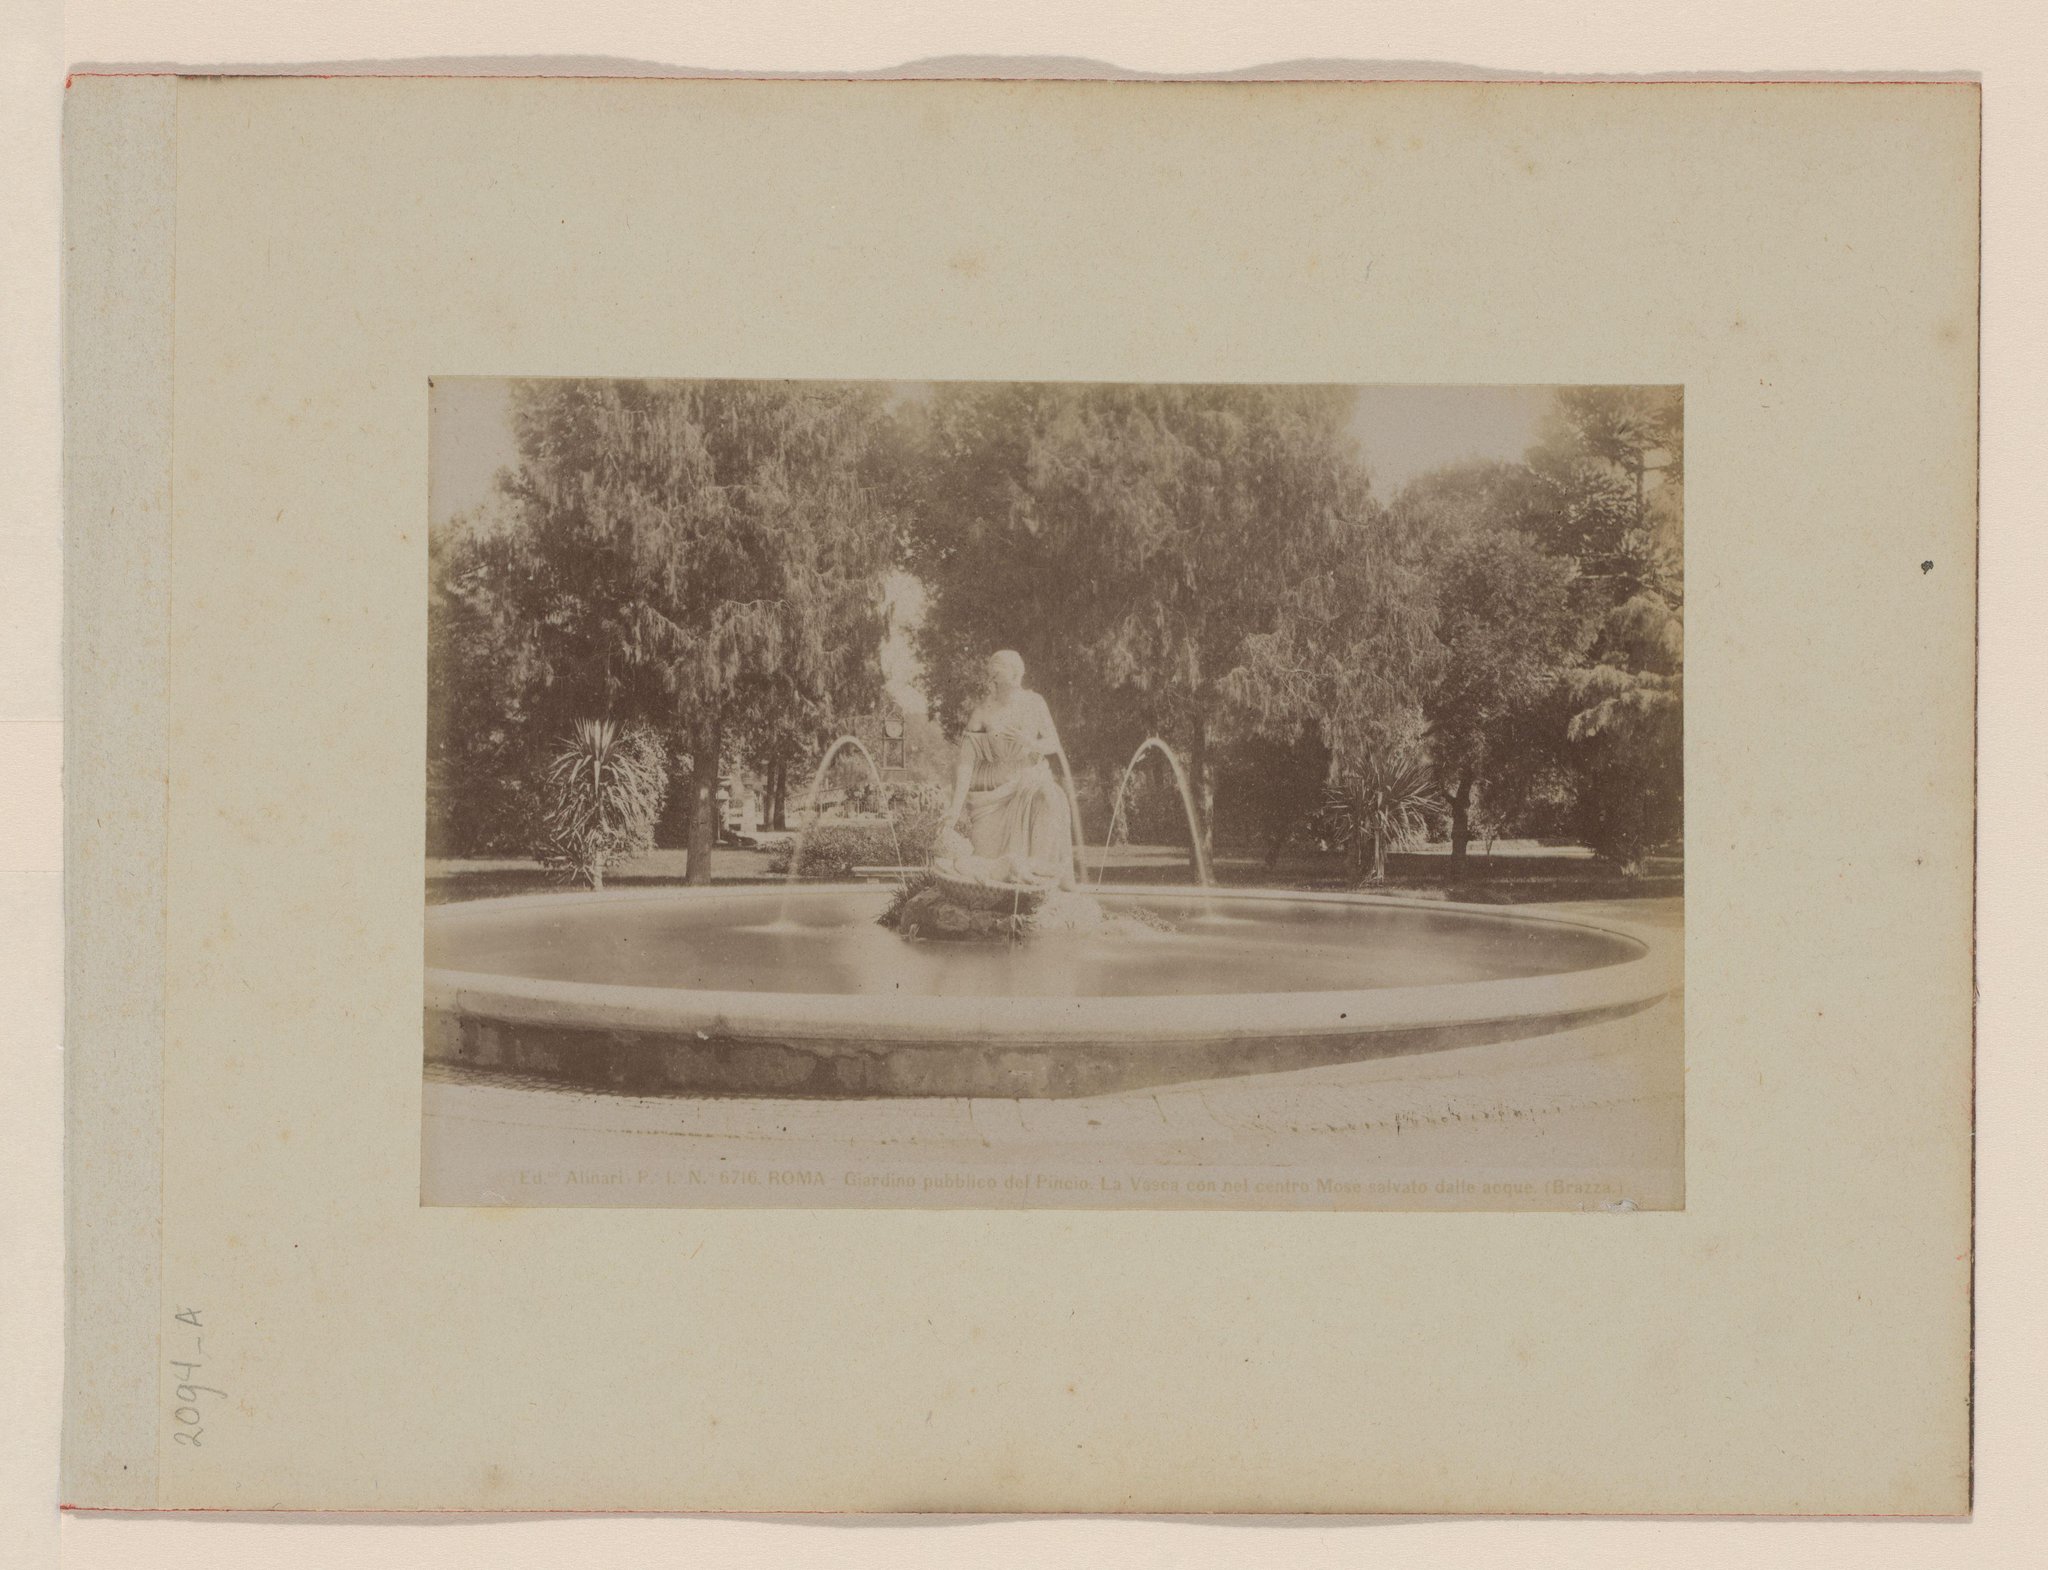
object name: photograph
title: Roma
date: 1857-1900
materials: cardboard, paper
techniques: albumen print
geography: rome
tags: ornamental fountain, public gardens, park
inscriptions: number: ‘Po. Io. No. 6716.’